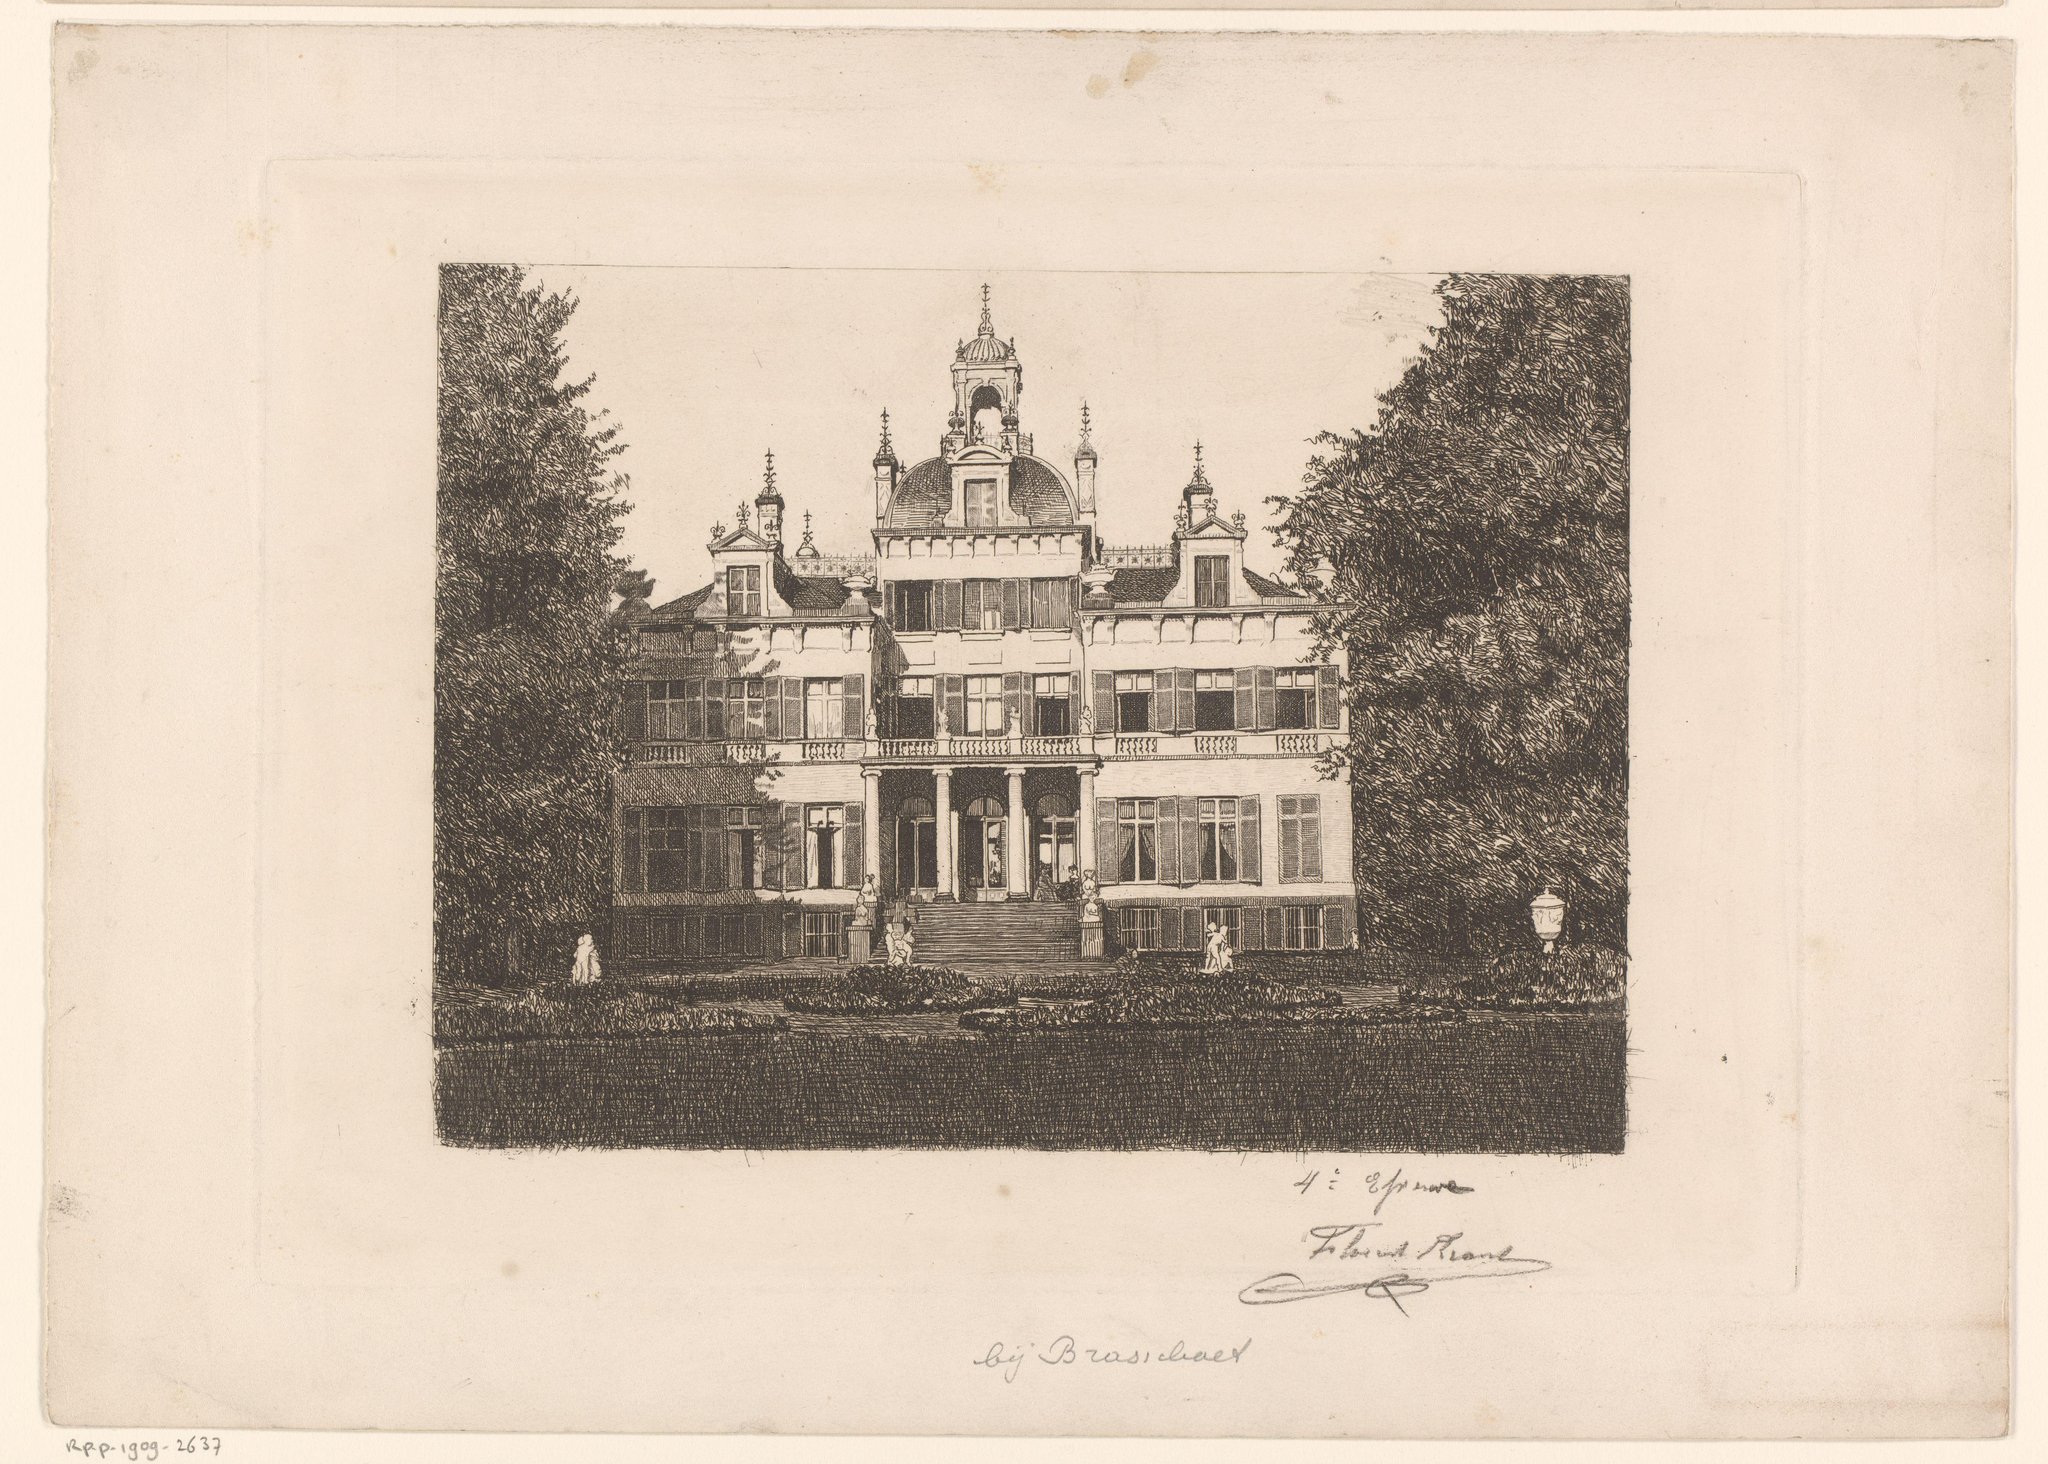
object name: print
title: Hof ter Mick te Brasschaat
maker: florent brant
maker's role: print maker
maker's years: 1863-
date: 1873-1909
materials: paper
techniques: etching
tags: castle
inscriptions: collector's mark: Lugt 2228, inscription: ‘4e Epreuve’